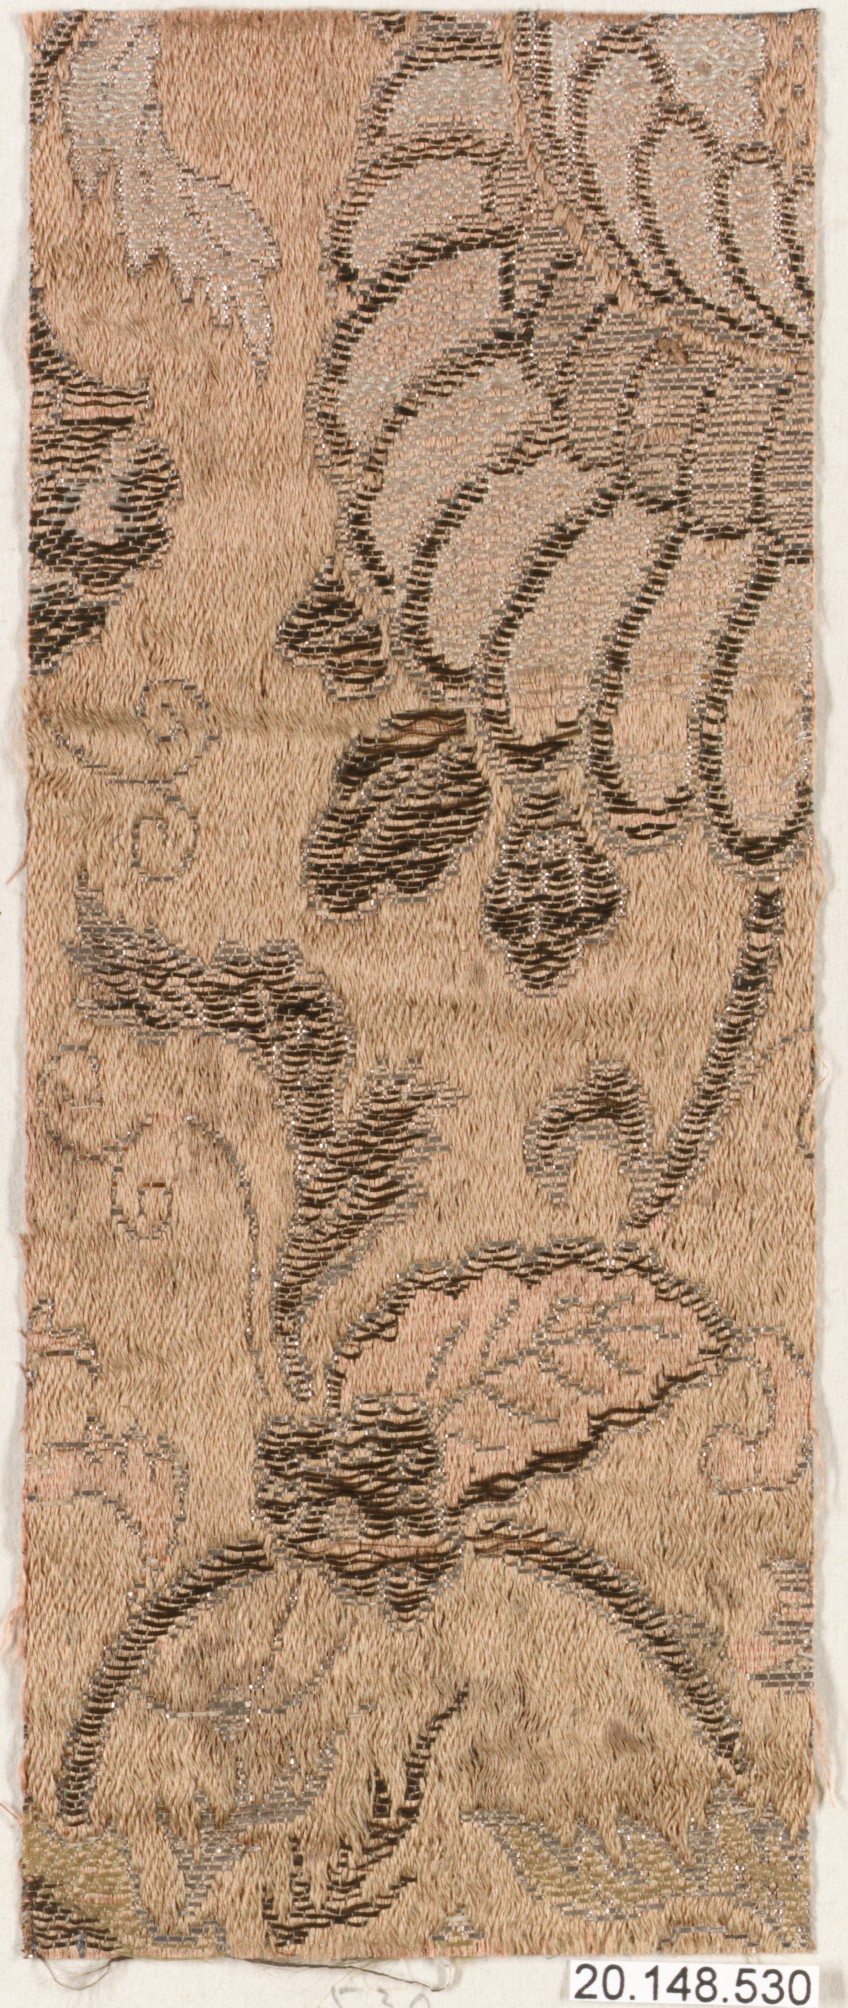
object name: piece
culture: japanese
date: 1601-1700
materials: silk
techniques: compound weave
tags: flowers,leaves